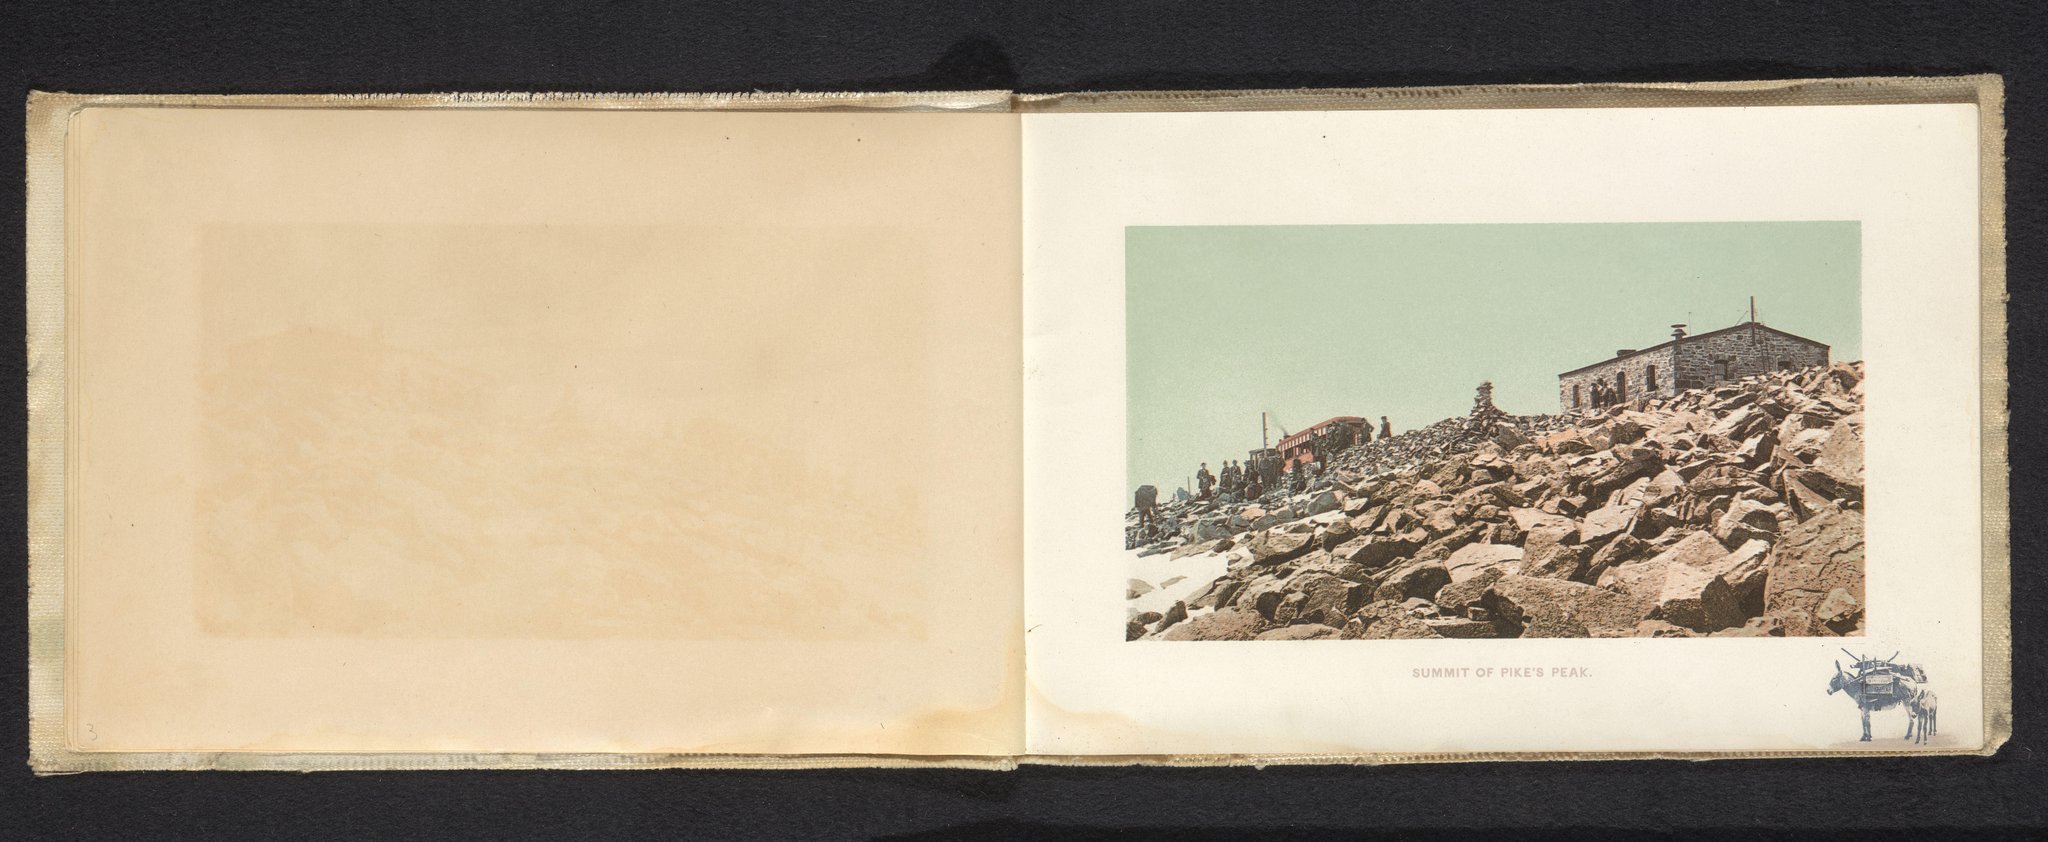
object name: photomechanical print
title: Gezicht op de top van Pike's Peak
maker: Anonymous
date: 1894-1899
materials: paper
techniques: lithograph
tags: mountain-top, peak